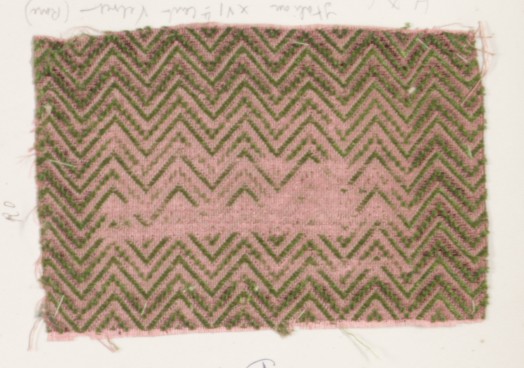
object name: fragment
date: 1501-1600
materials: silk